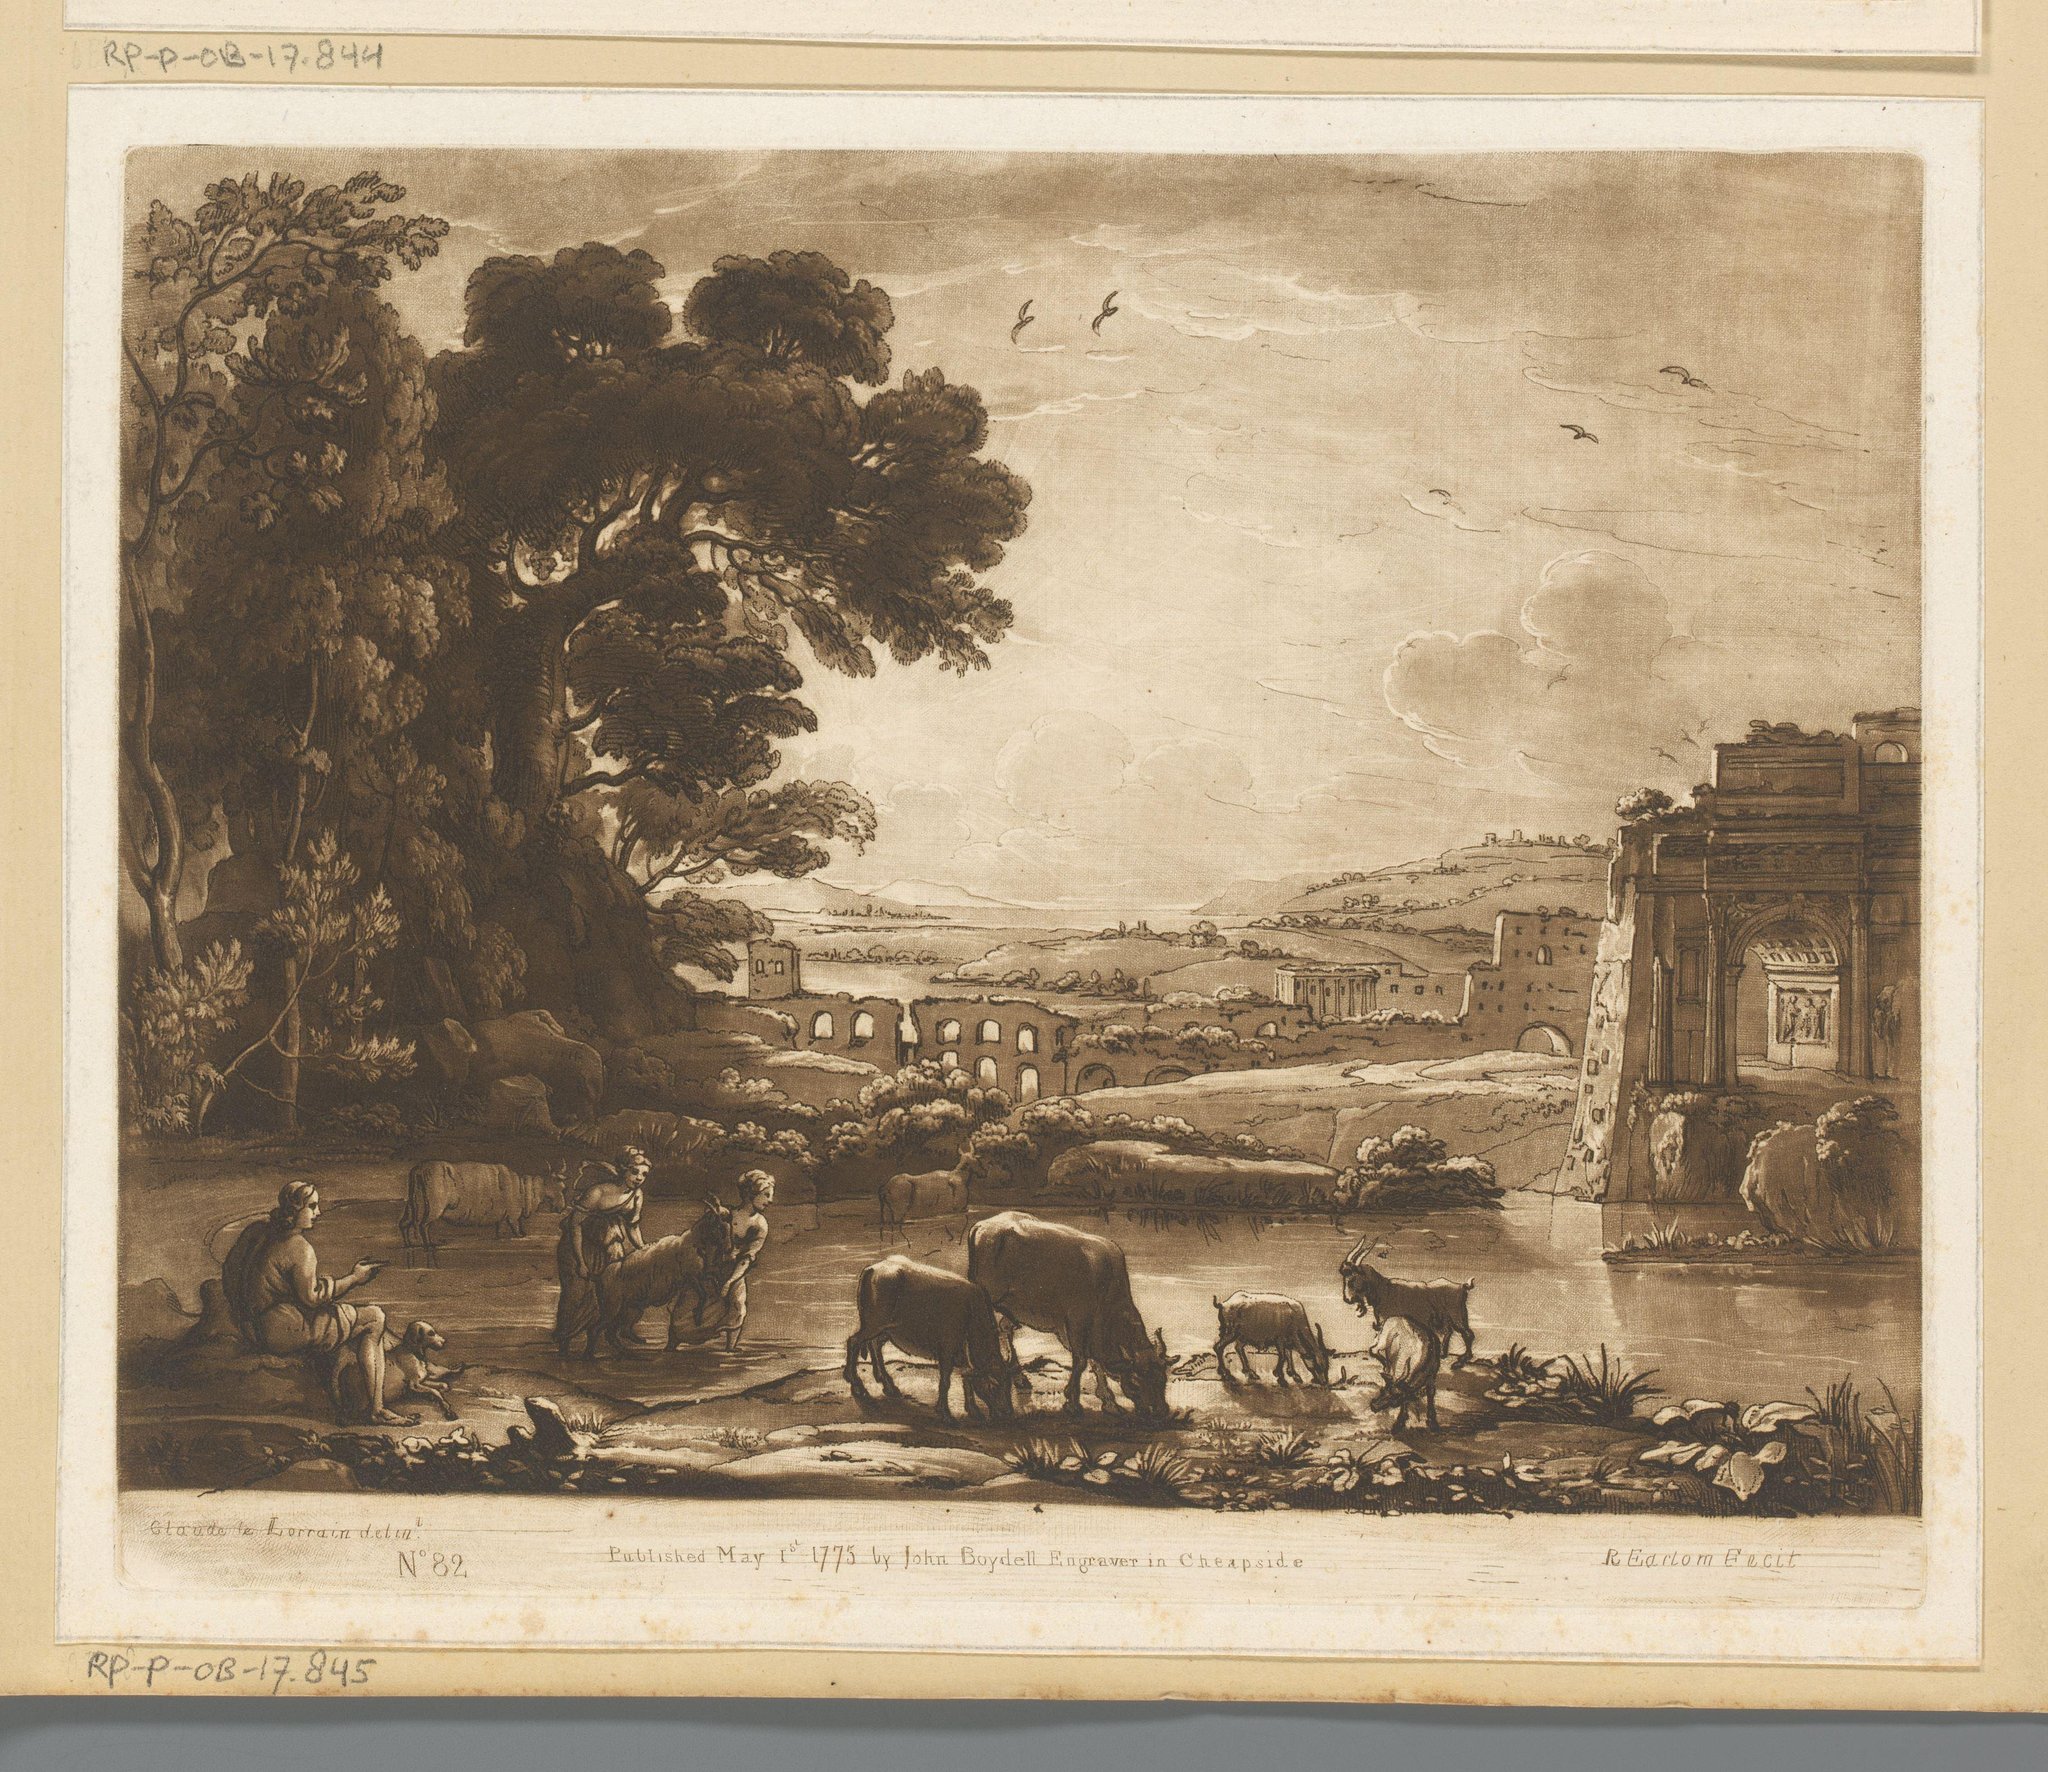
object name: print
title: Landschap met herders, vee en triomfboog rond een meer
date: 1775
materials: paper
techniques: etching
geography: london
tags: viaduct, herding, herdsman, herdswoman, shepherd, shepherdess, cowherd, etc., triumphal arch, landscape with ruins - ii - ideal landscapes, pastorals, arcadian scenes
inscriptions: date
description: Vanaf 1774 publiceerde John Boydell tweehonderd prenten naar het tekeningenboek Liber Veritatis van Claude Lorrain, in het bezit van de hertogen van Cavendish. Deze prenten werden vanaf 1777 in twee volumes gebundeld uitgegeven.